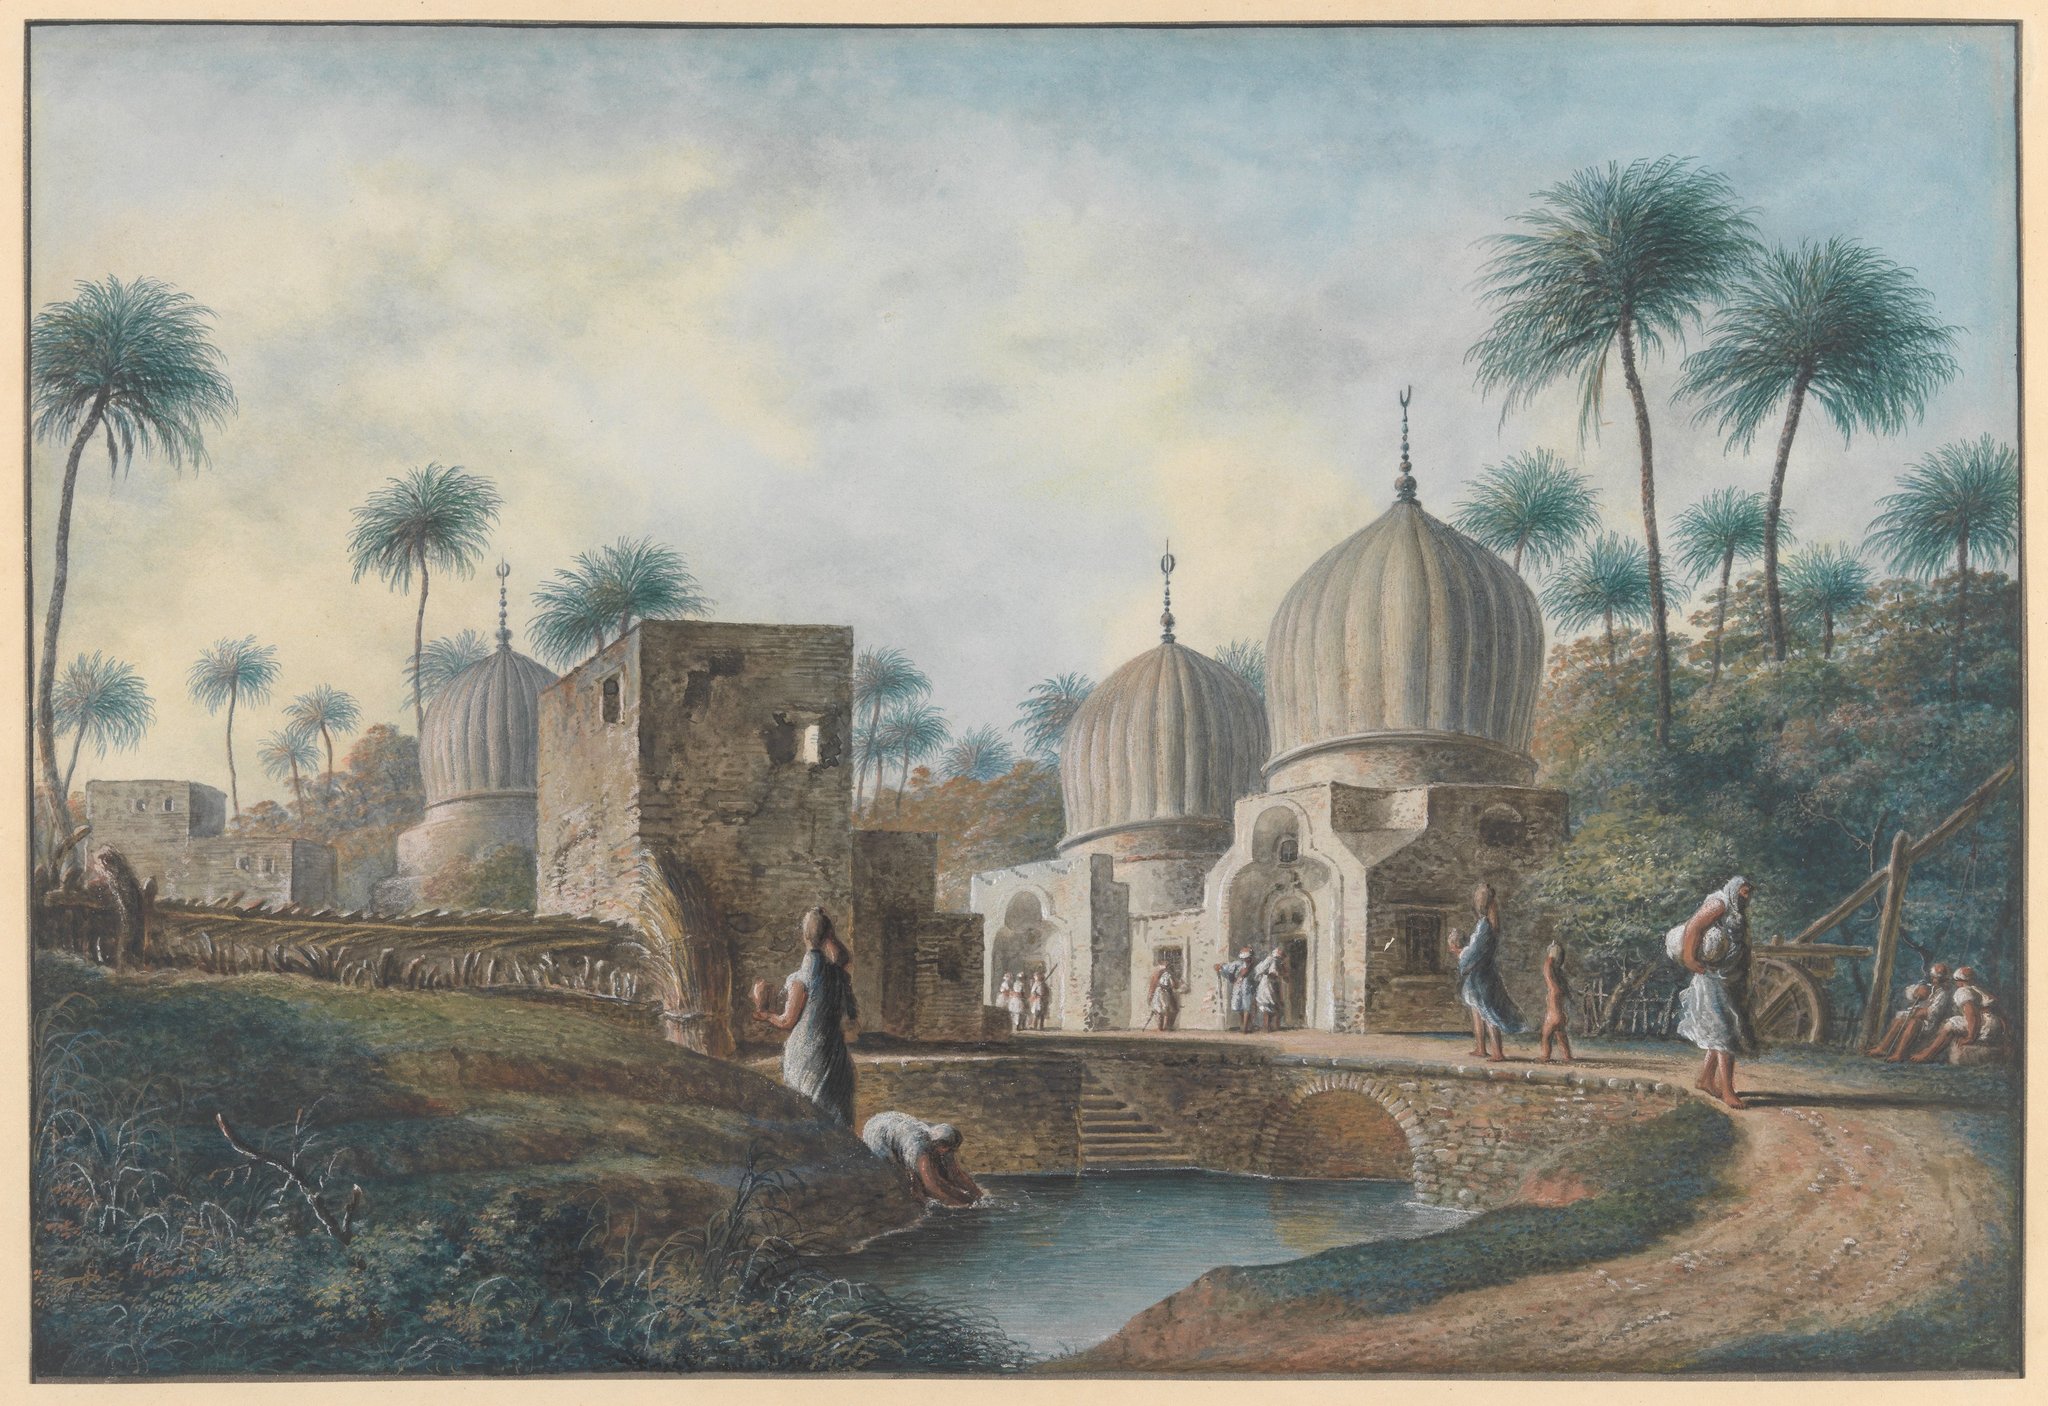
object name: drawing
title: Tombs of Great Arab Saints to be seen in the Neighborhood of Rosetta, Egypt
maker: luigi mayer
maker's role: artist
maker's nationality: italian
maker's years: 1755-1803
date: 1800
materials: paint, graphite, watercolor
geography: egypt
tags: tombs